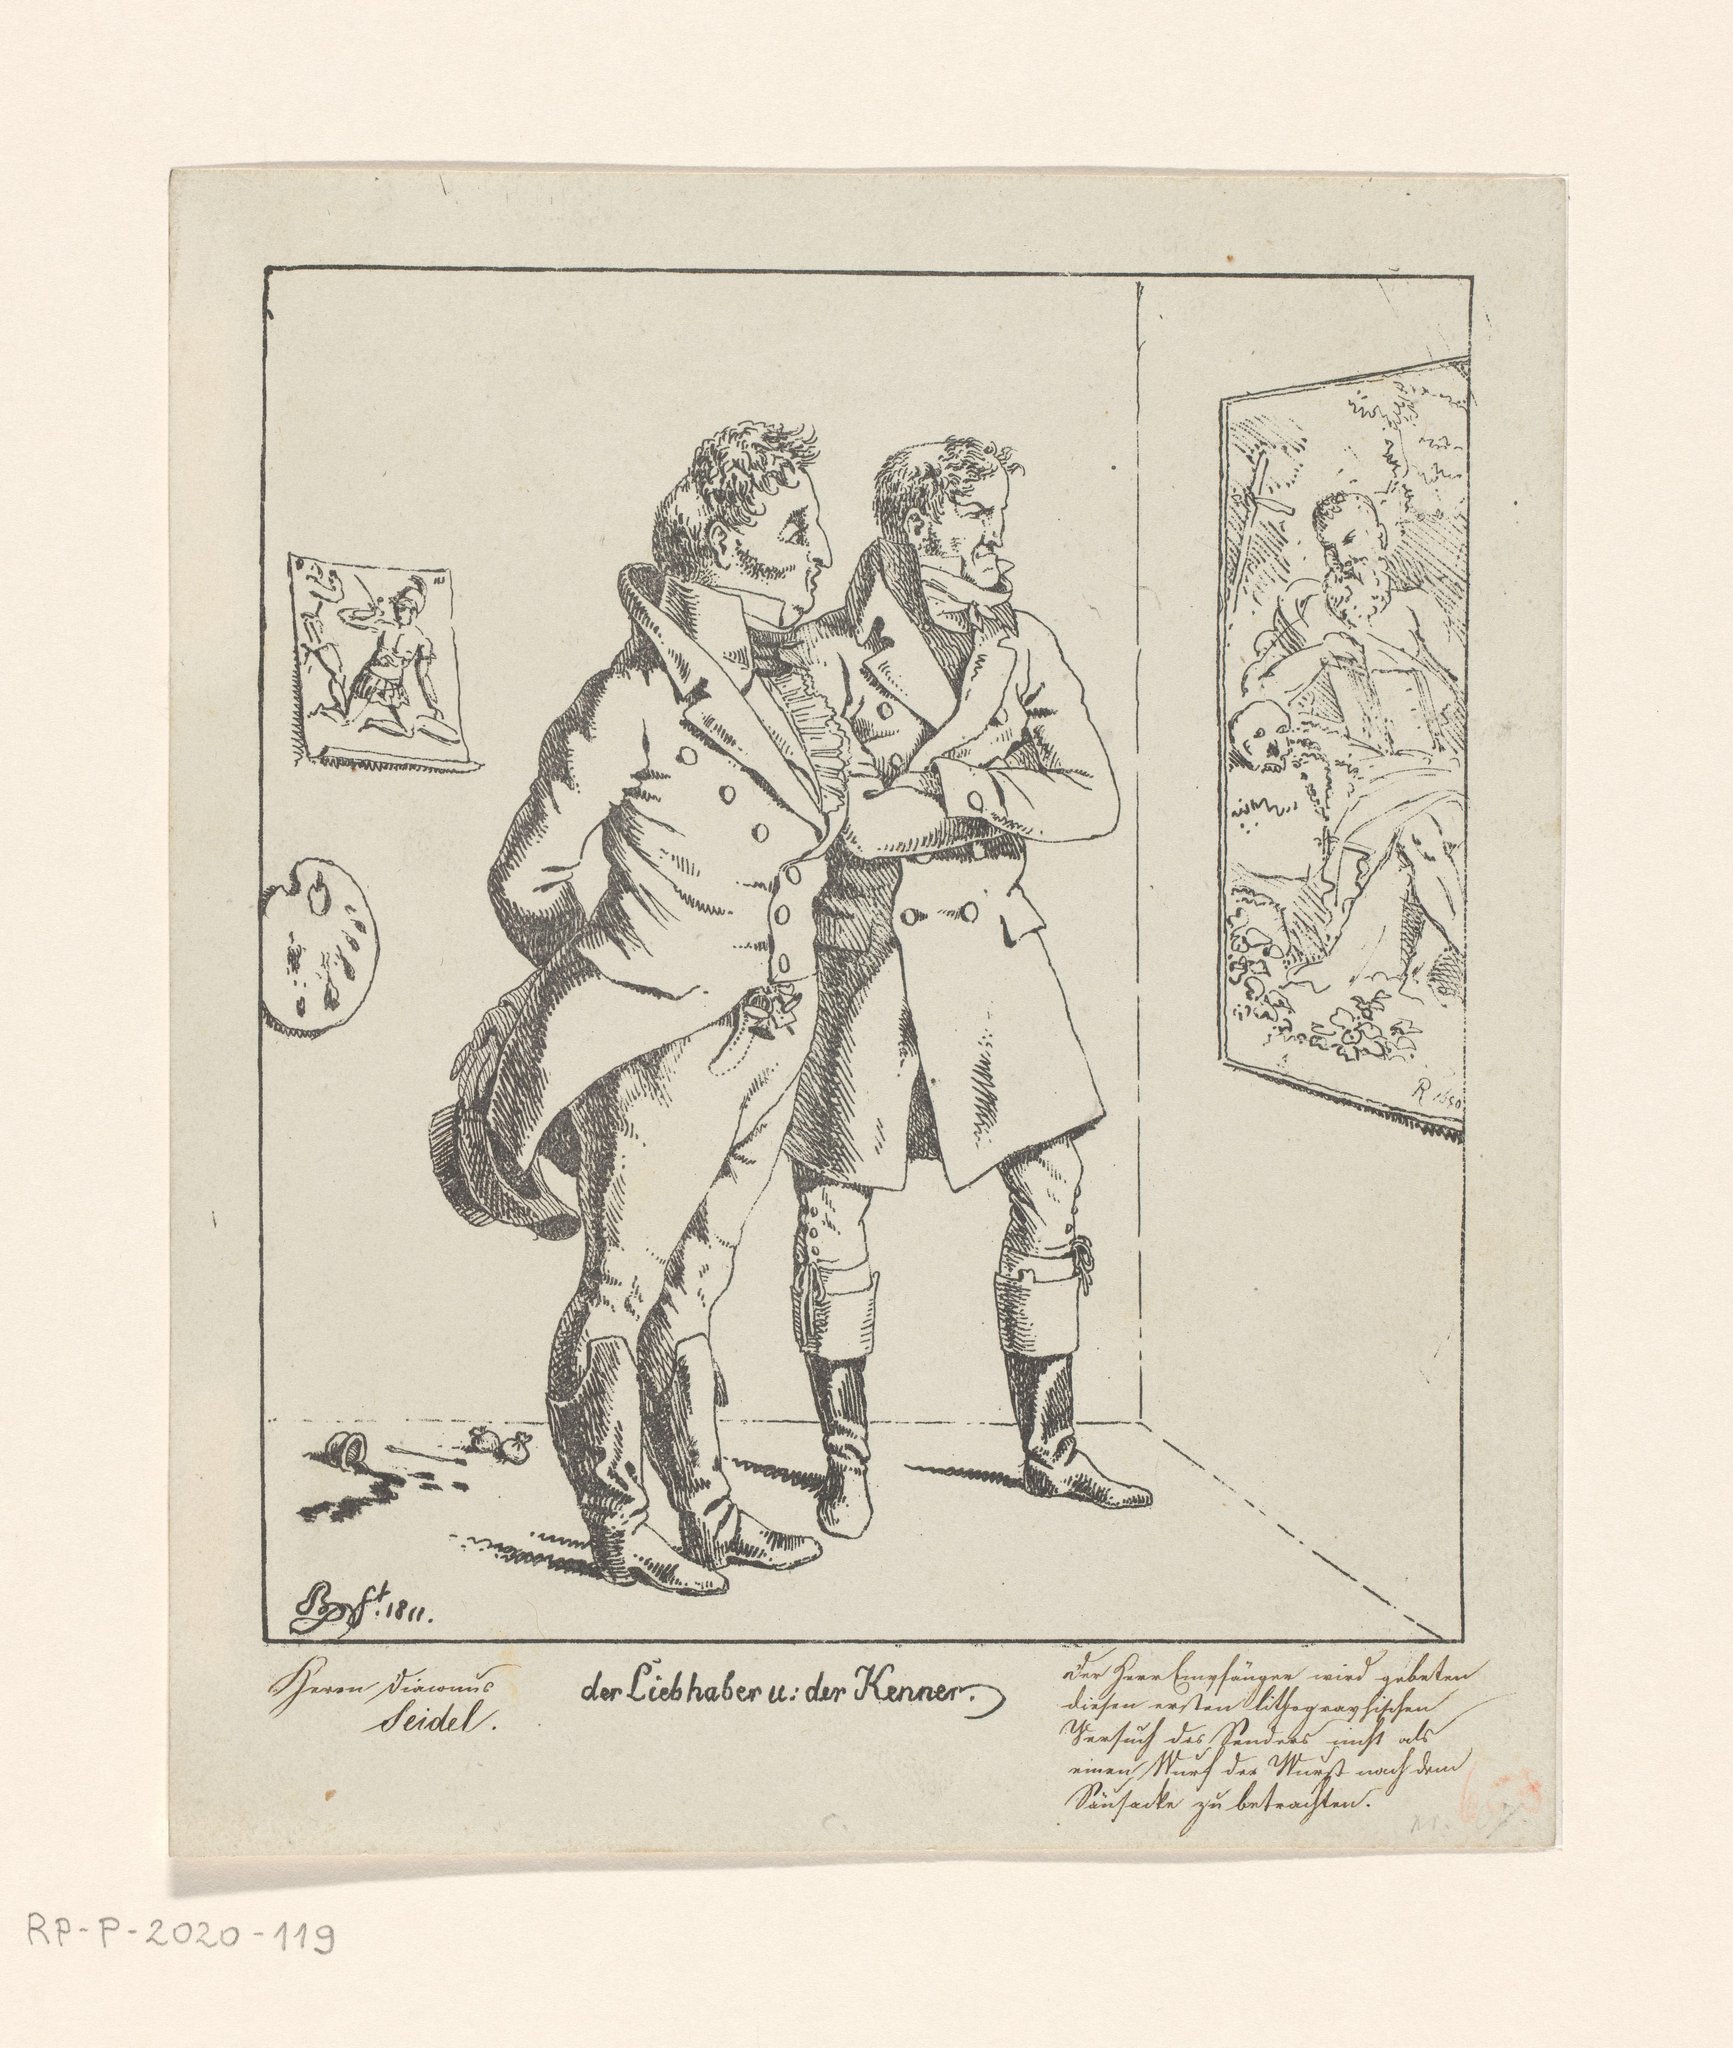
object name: print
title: Een kunstliefhebber en een kunstkenner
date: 1811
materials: paper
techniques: lithograph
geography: nuremberg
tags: criticizing and discussing art, art criticism, art collection, art gallery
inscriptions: collector's mark: Lugt 2228, inscription: ‘Herrn Diaconus Seidel. Der Herr Empfänger wird gebeten diesen ersten lithographischen Versuch des Senders nicht als einen Wurf der Wurst nach dem Sausacke zu betrachten.’, collector's mark: Lugt 2760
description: Karikaturen van een kunstliefhebber en een kunstkenner kijkend naar een schilderij in een schildersatelier.